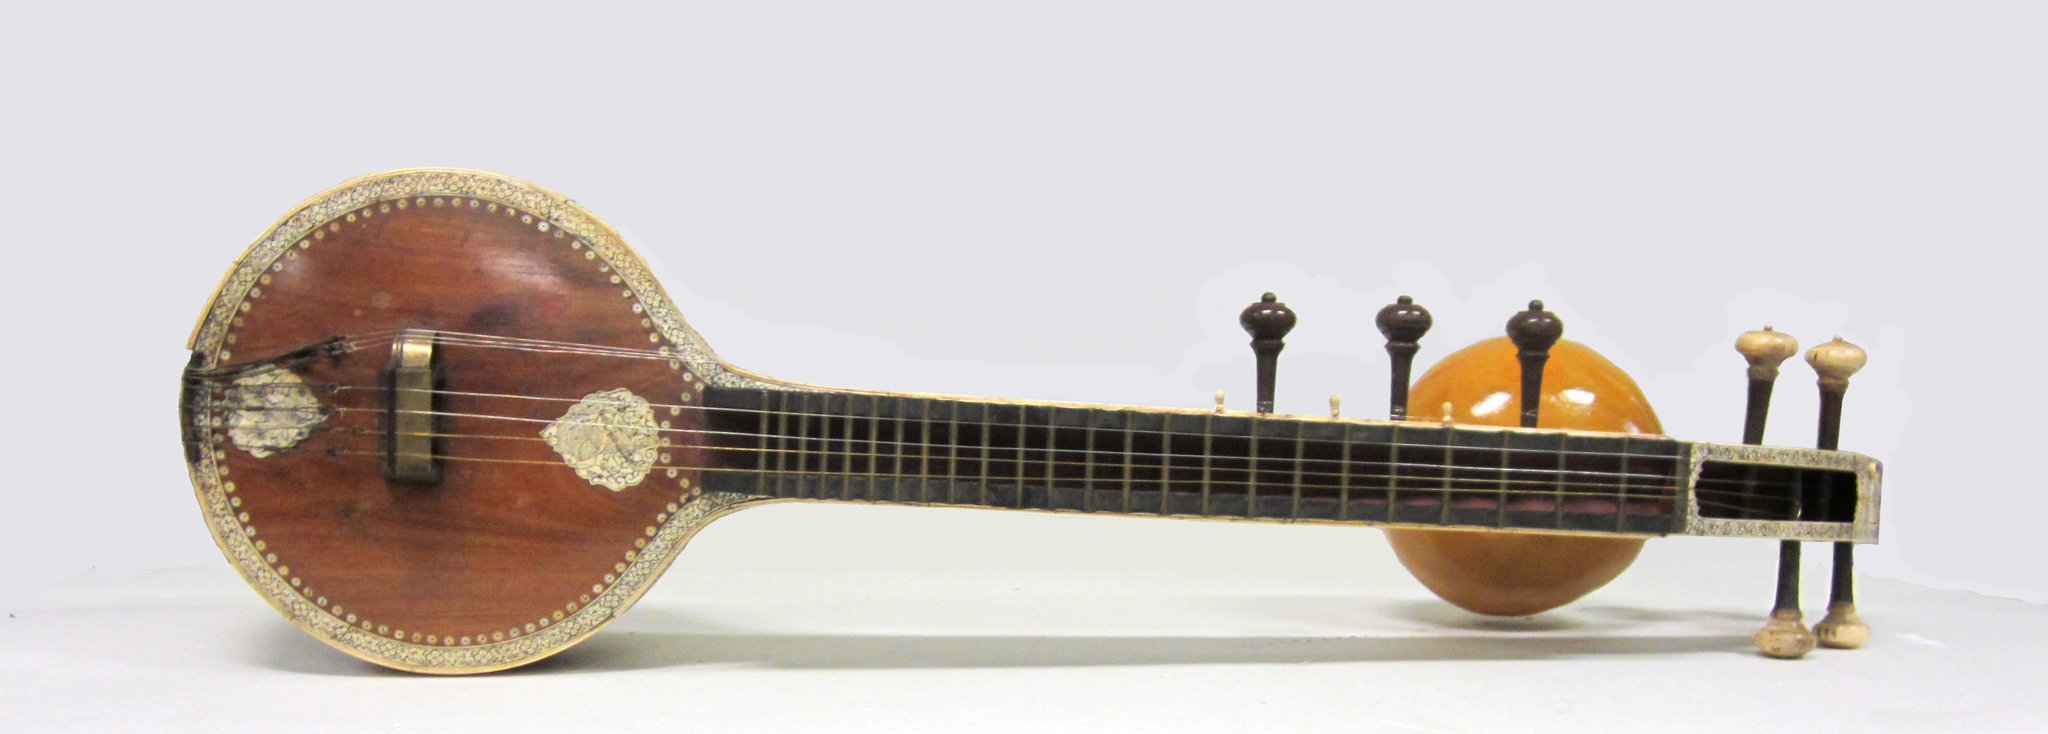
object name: ekadandi vina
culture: indian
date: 1801-1900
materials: bone, metal, wood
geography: india